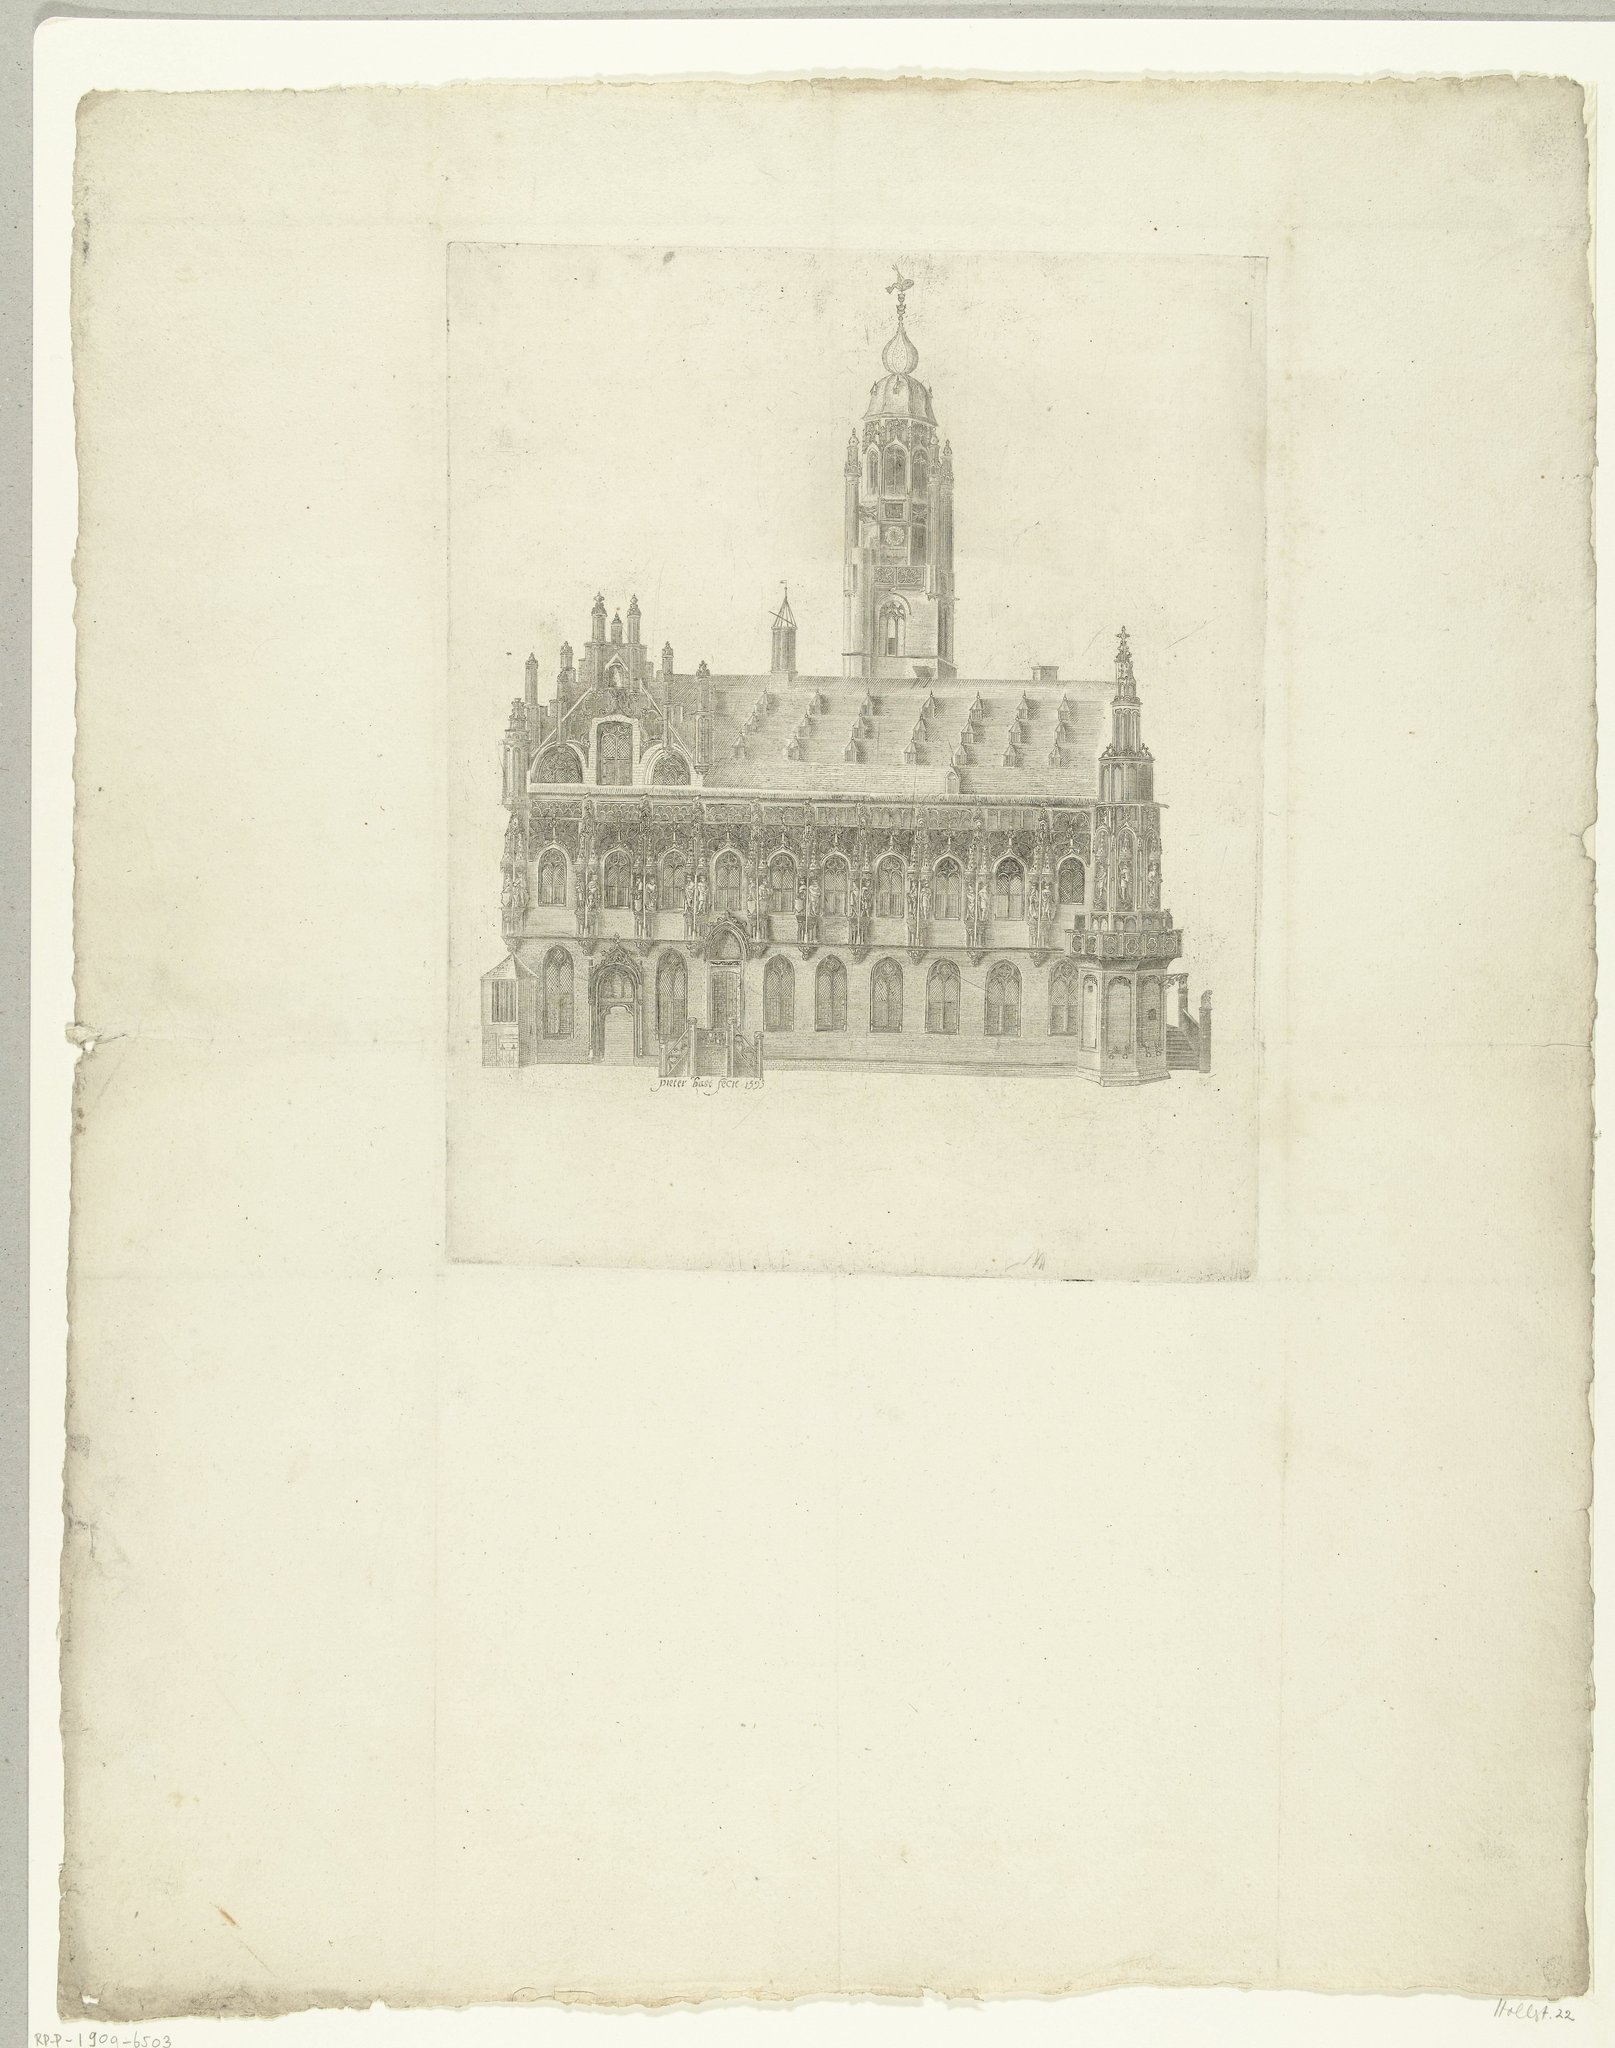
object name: book illustration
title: Gezicht op het stadhuis van Middelburg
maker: pieter bast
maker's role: print maker, publisher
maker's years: 1570-1605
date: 1595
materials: paper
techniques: engraving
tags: townhall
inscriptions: collector's mark: Lugt 2228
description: Deze staat van prent komt ook voor in enkele exemplaren van: Guicciardini, Lodovico. Beschryvinghe van alle de Neder-landen, anderssins ghenoemt Neder-Duytslandt (…). Amsterdam: Willem Janszoon Blaeu, 1612. En in enkele exemplaren van latere uitgaven van deze publicatie, uitgegeven door Blaeu (1613) en Johannes Janssonius (1625 en 1648). Zie RP-P-AO-15-50 voor tweede staat.